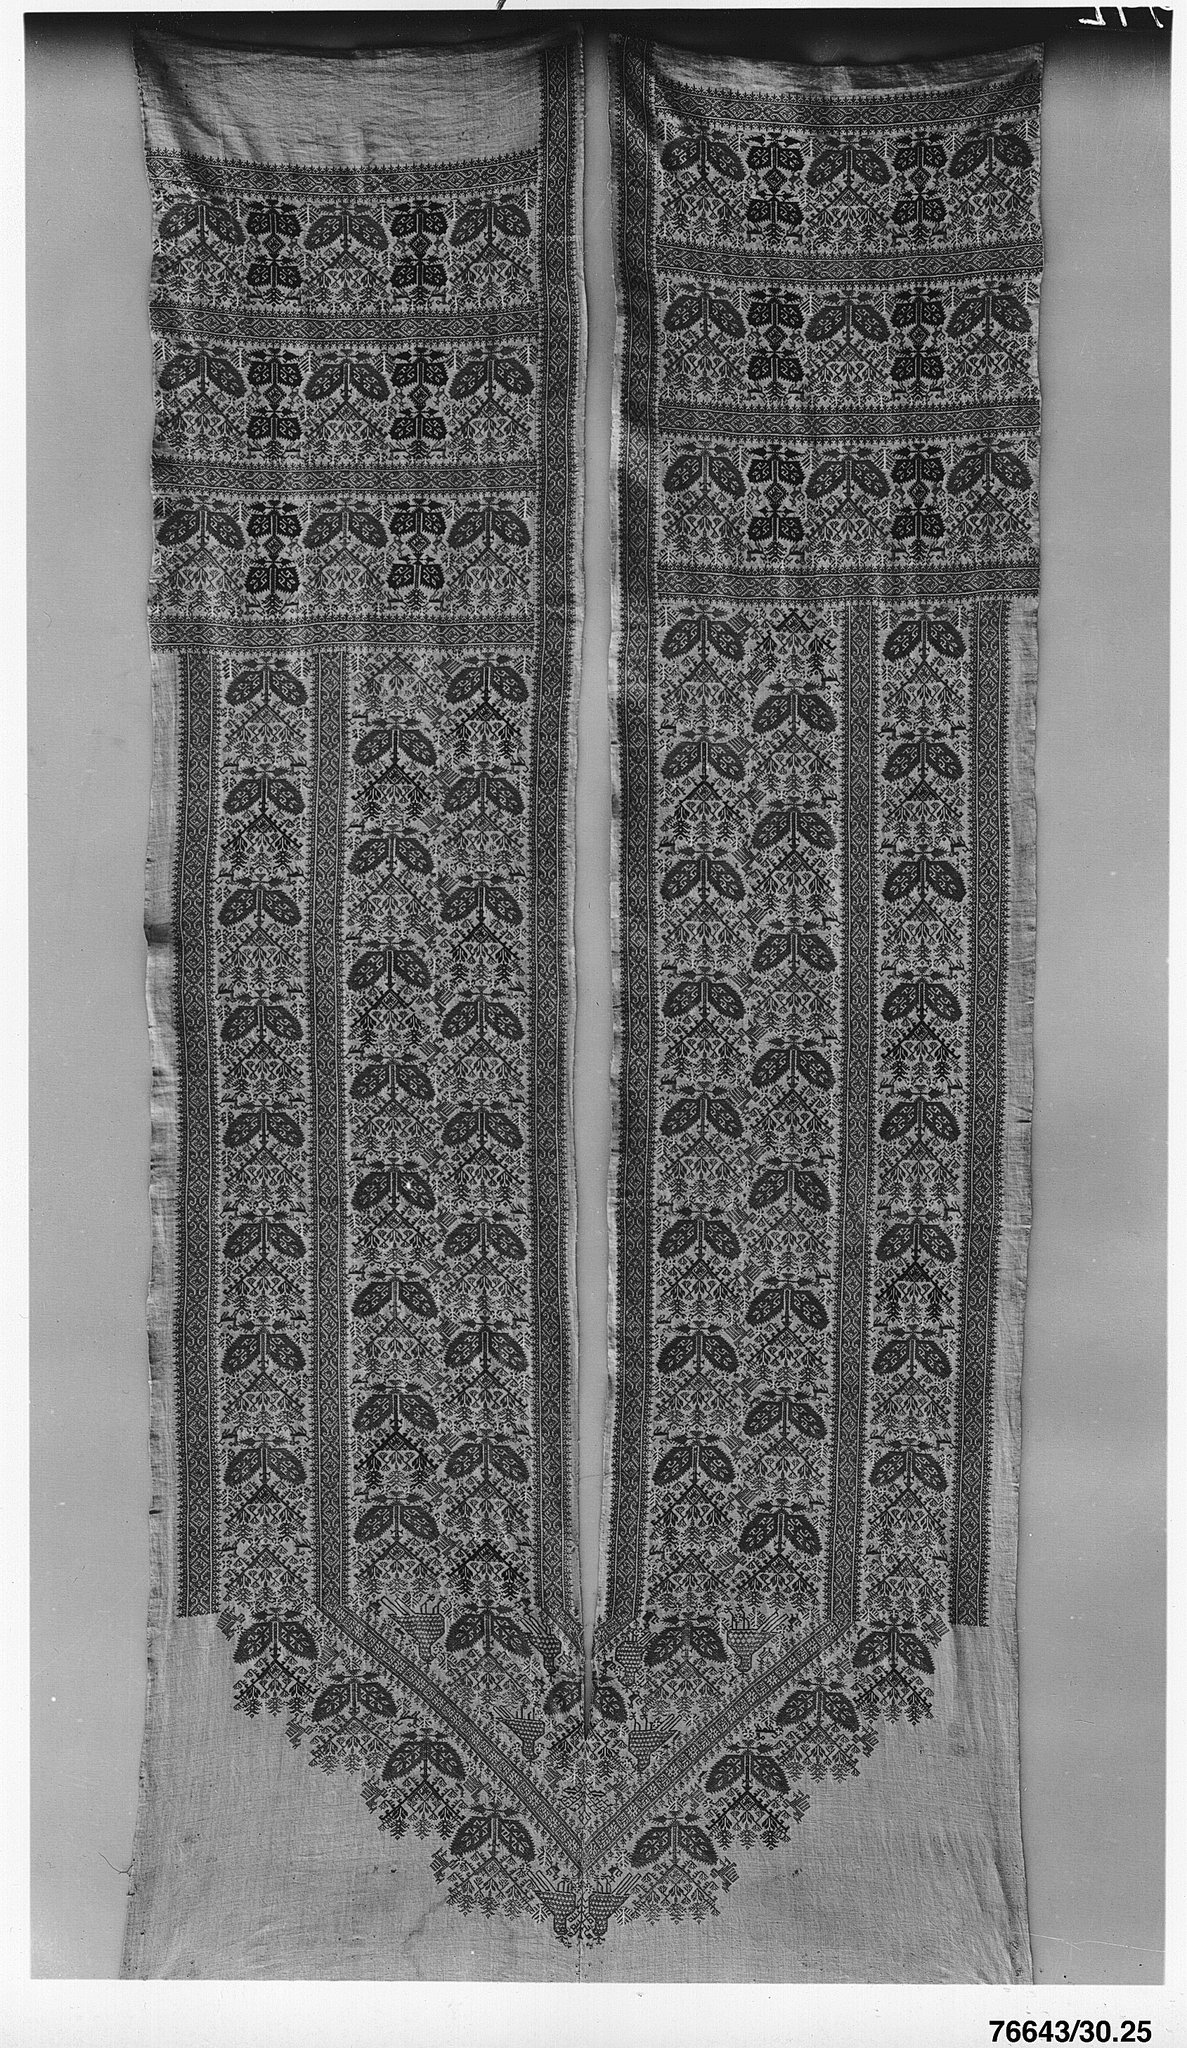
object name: curtain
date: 1601-1700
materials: linen, silk